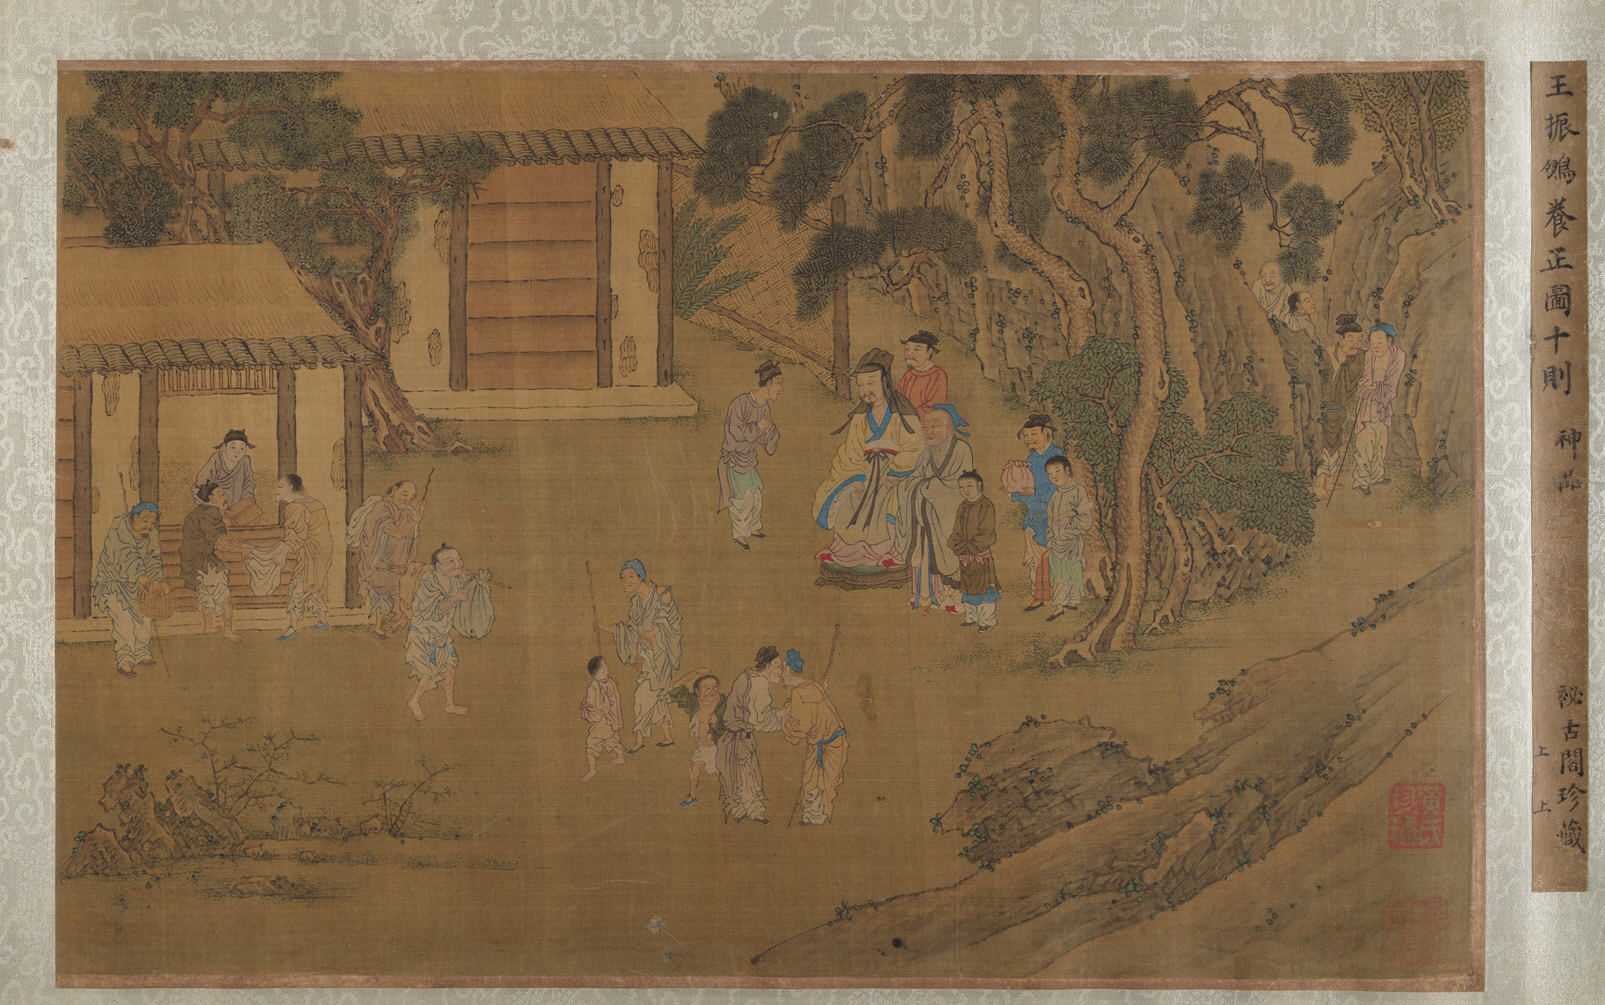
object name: panel mounted a a handscroll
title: Family Training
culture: chinese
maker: unidentified artist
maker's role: artist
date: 1600-1913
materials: ink, panel, silk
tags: children,men,women,family